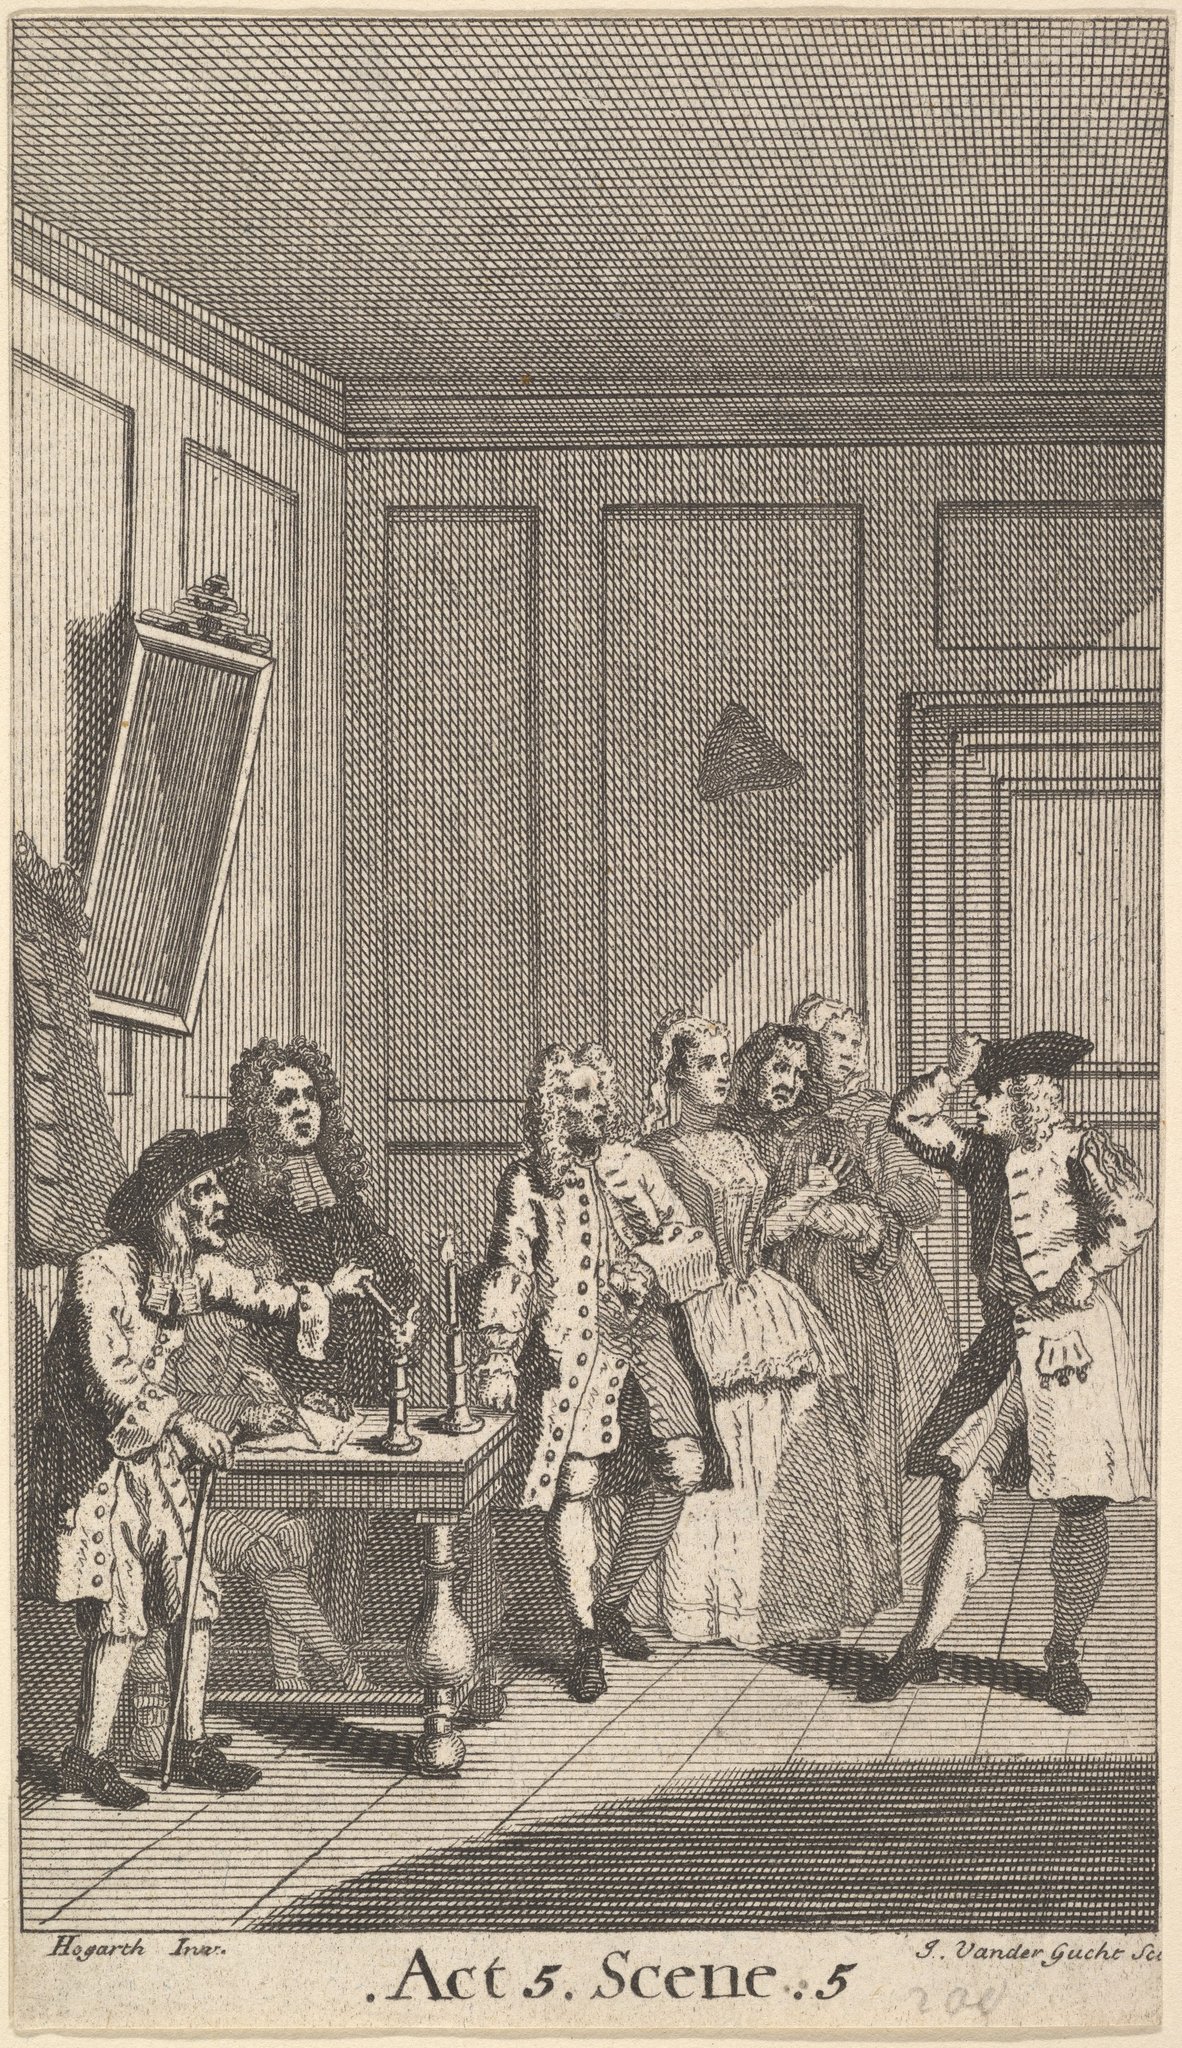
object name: print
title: Frontispiece to Moliere's "L'Avare" (The Miser)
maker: john vandergucht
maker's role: etcher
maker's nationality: british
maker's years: 1697-1732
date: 1732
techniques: engraving, etching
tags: men,women